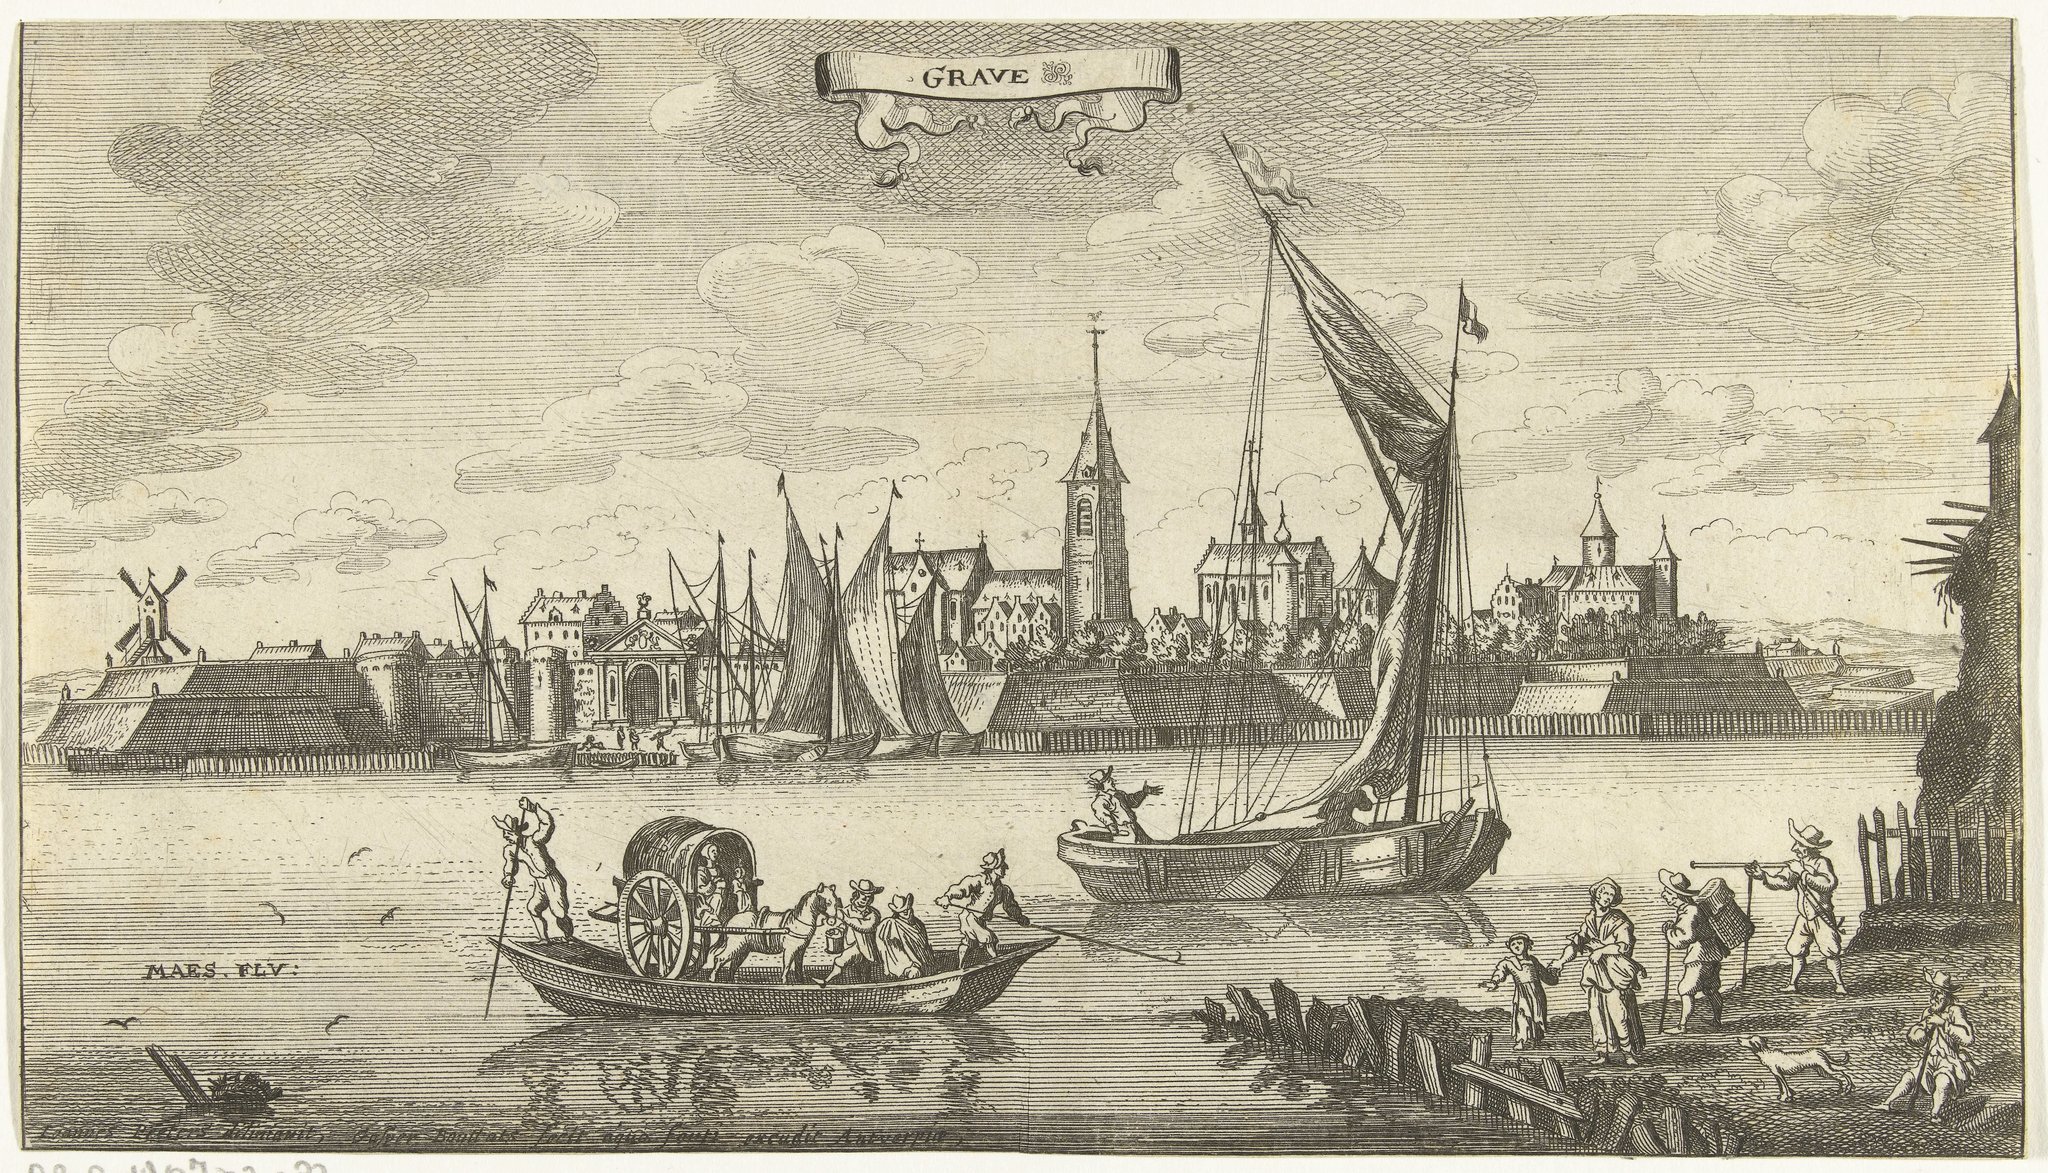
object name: print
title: Steden en vestigingen in de Republiek der Nederlanden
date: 1679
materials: paper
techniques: etching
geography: antwerp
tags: prospect of city, town panorama, silhouette of city, grave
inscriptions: collector's mark: Lugt 2228, inscription: ‘Grave’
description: Gezicht op de vestingstad Grave. Op de voorgrond, buiten de stadsmuren, de rivier De Maas. Een veerpont vaart over het water met een huifkar en passagiers. Op het vasteland staan andere passagiers te wachten. Boven het stadsgezicht een cartouche met de naam van de stad.